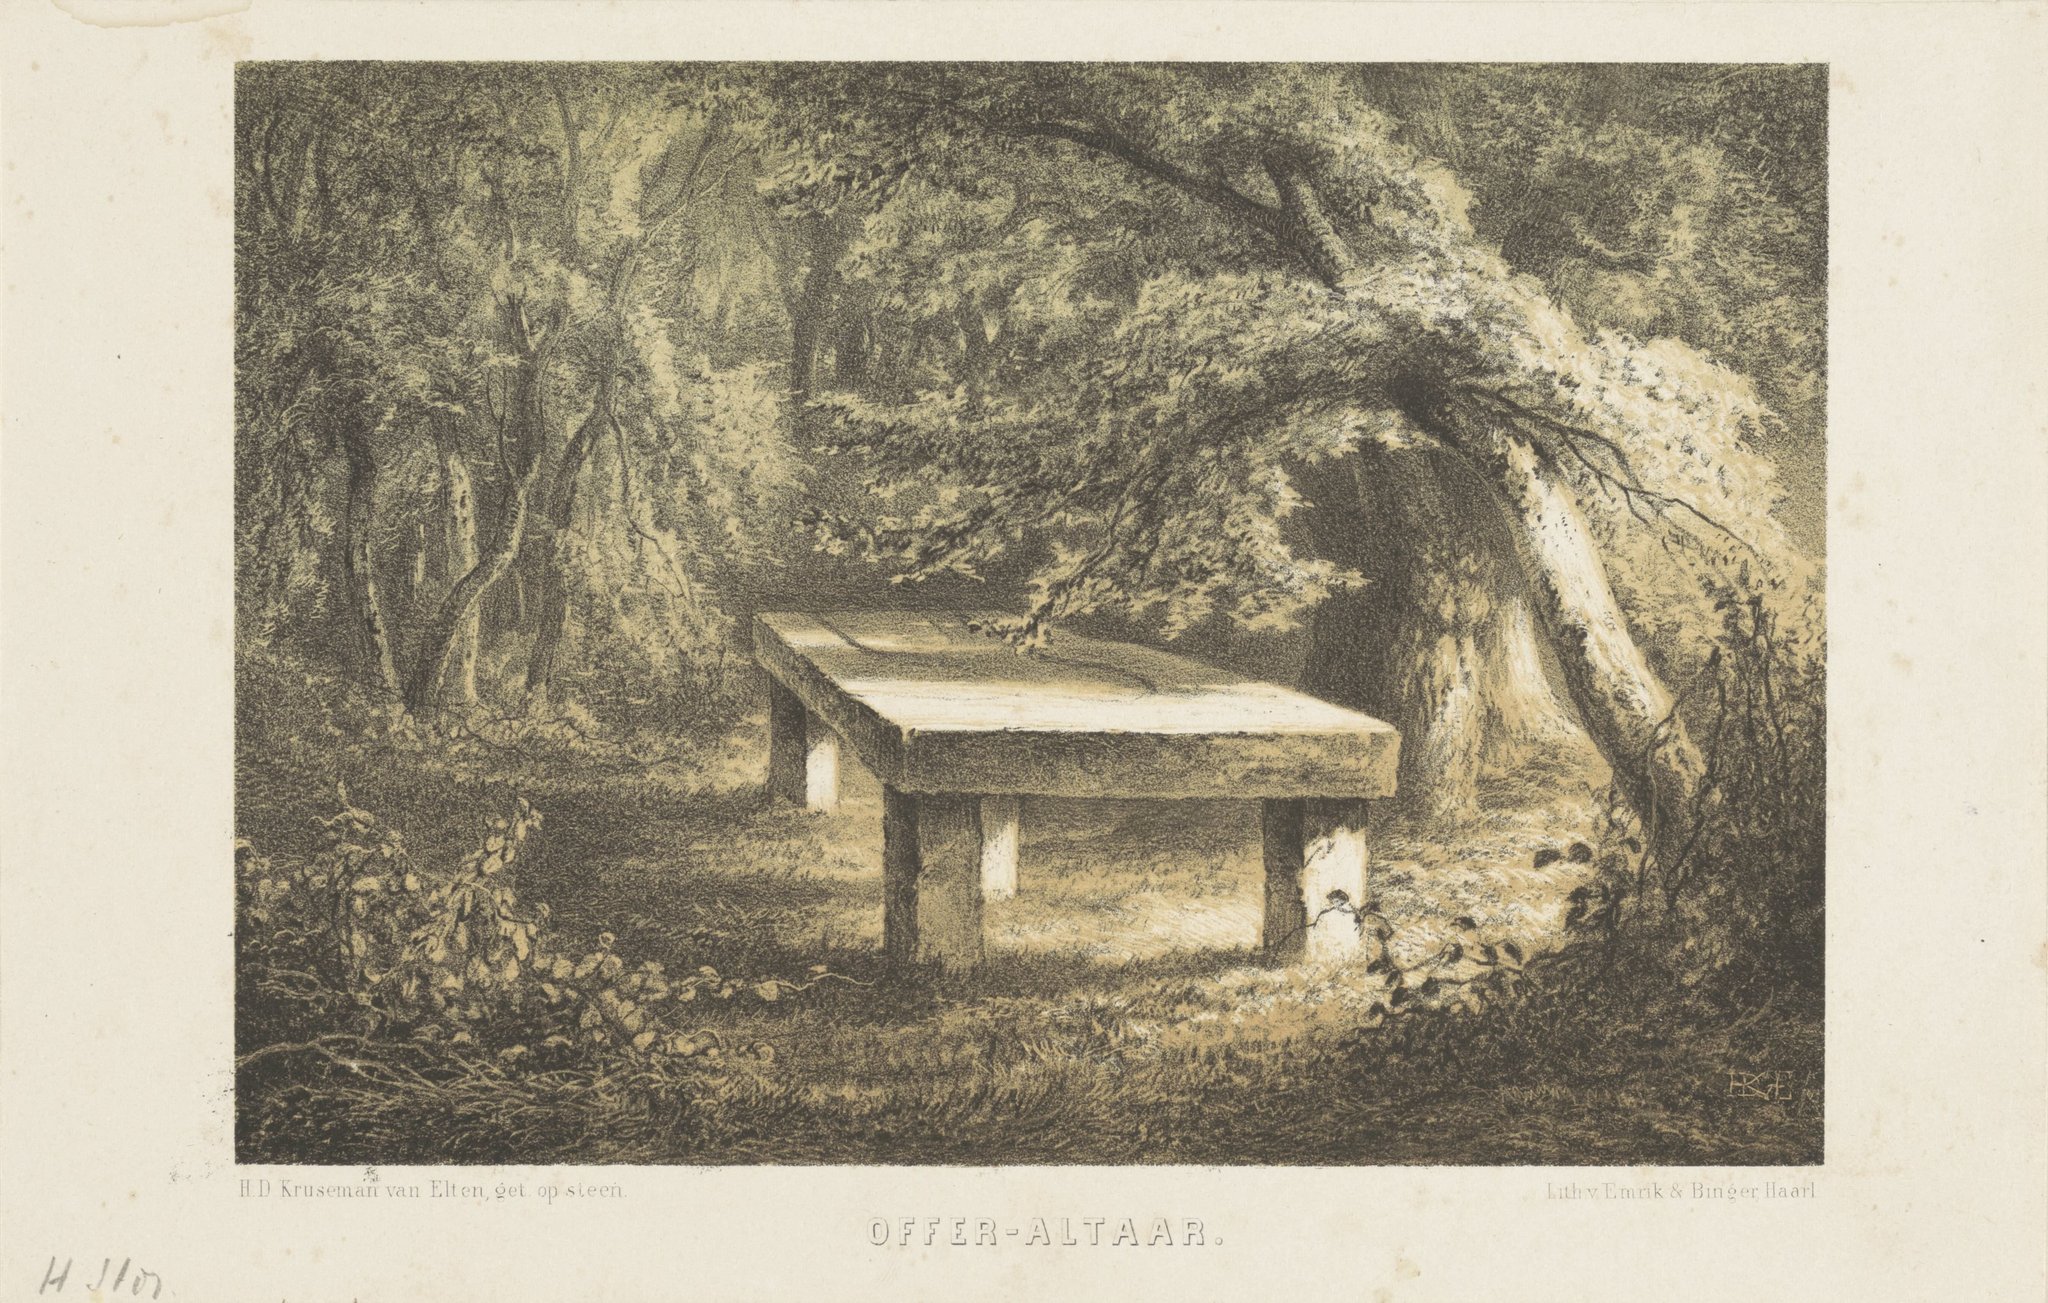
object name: print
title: Germaans offeraltaar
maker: hendrik dirk kruseman van elten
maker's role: draughtsman, print maker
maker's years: 1829-1904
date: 1839-1904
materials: paper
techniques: tone lithography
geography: haarlem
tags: sacrifice ~ germanic and scandinavian religions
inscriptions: collector's mark: Lugt 2228, collector's mark: Lugt 2760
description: Germaans stenen offeraltaar of offertafel in het bos.